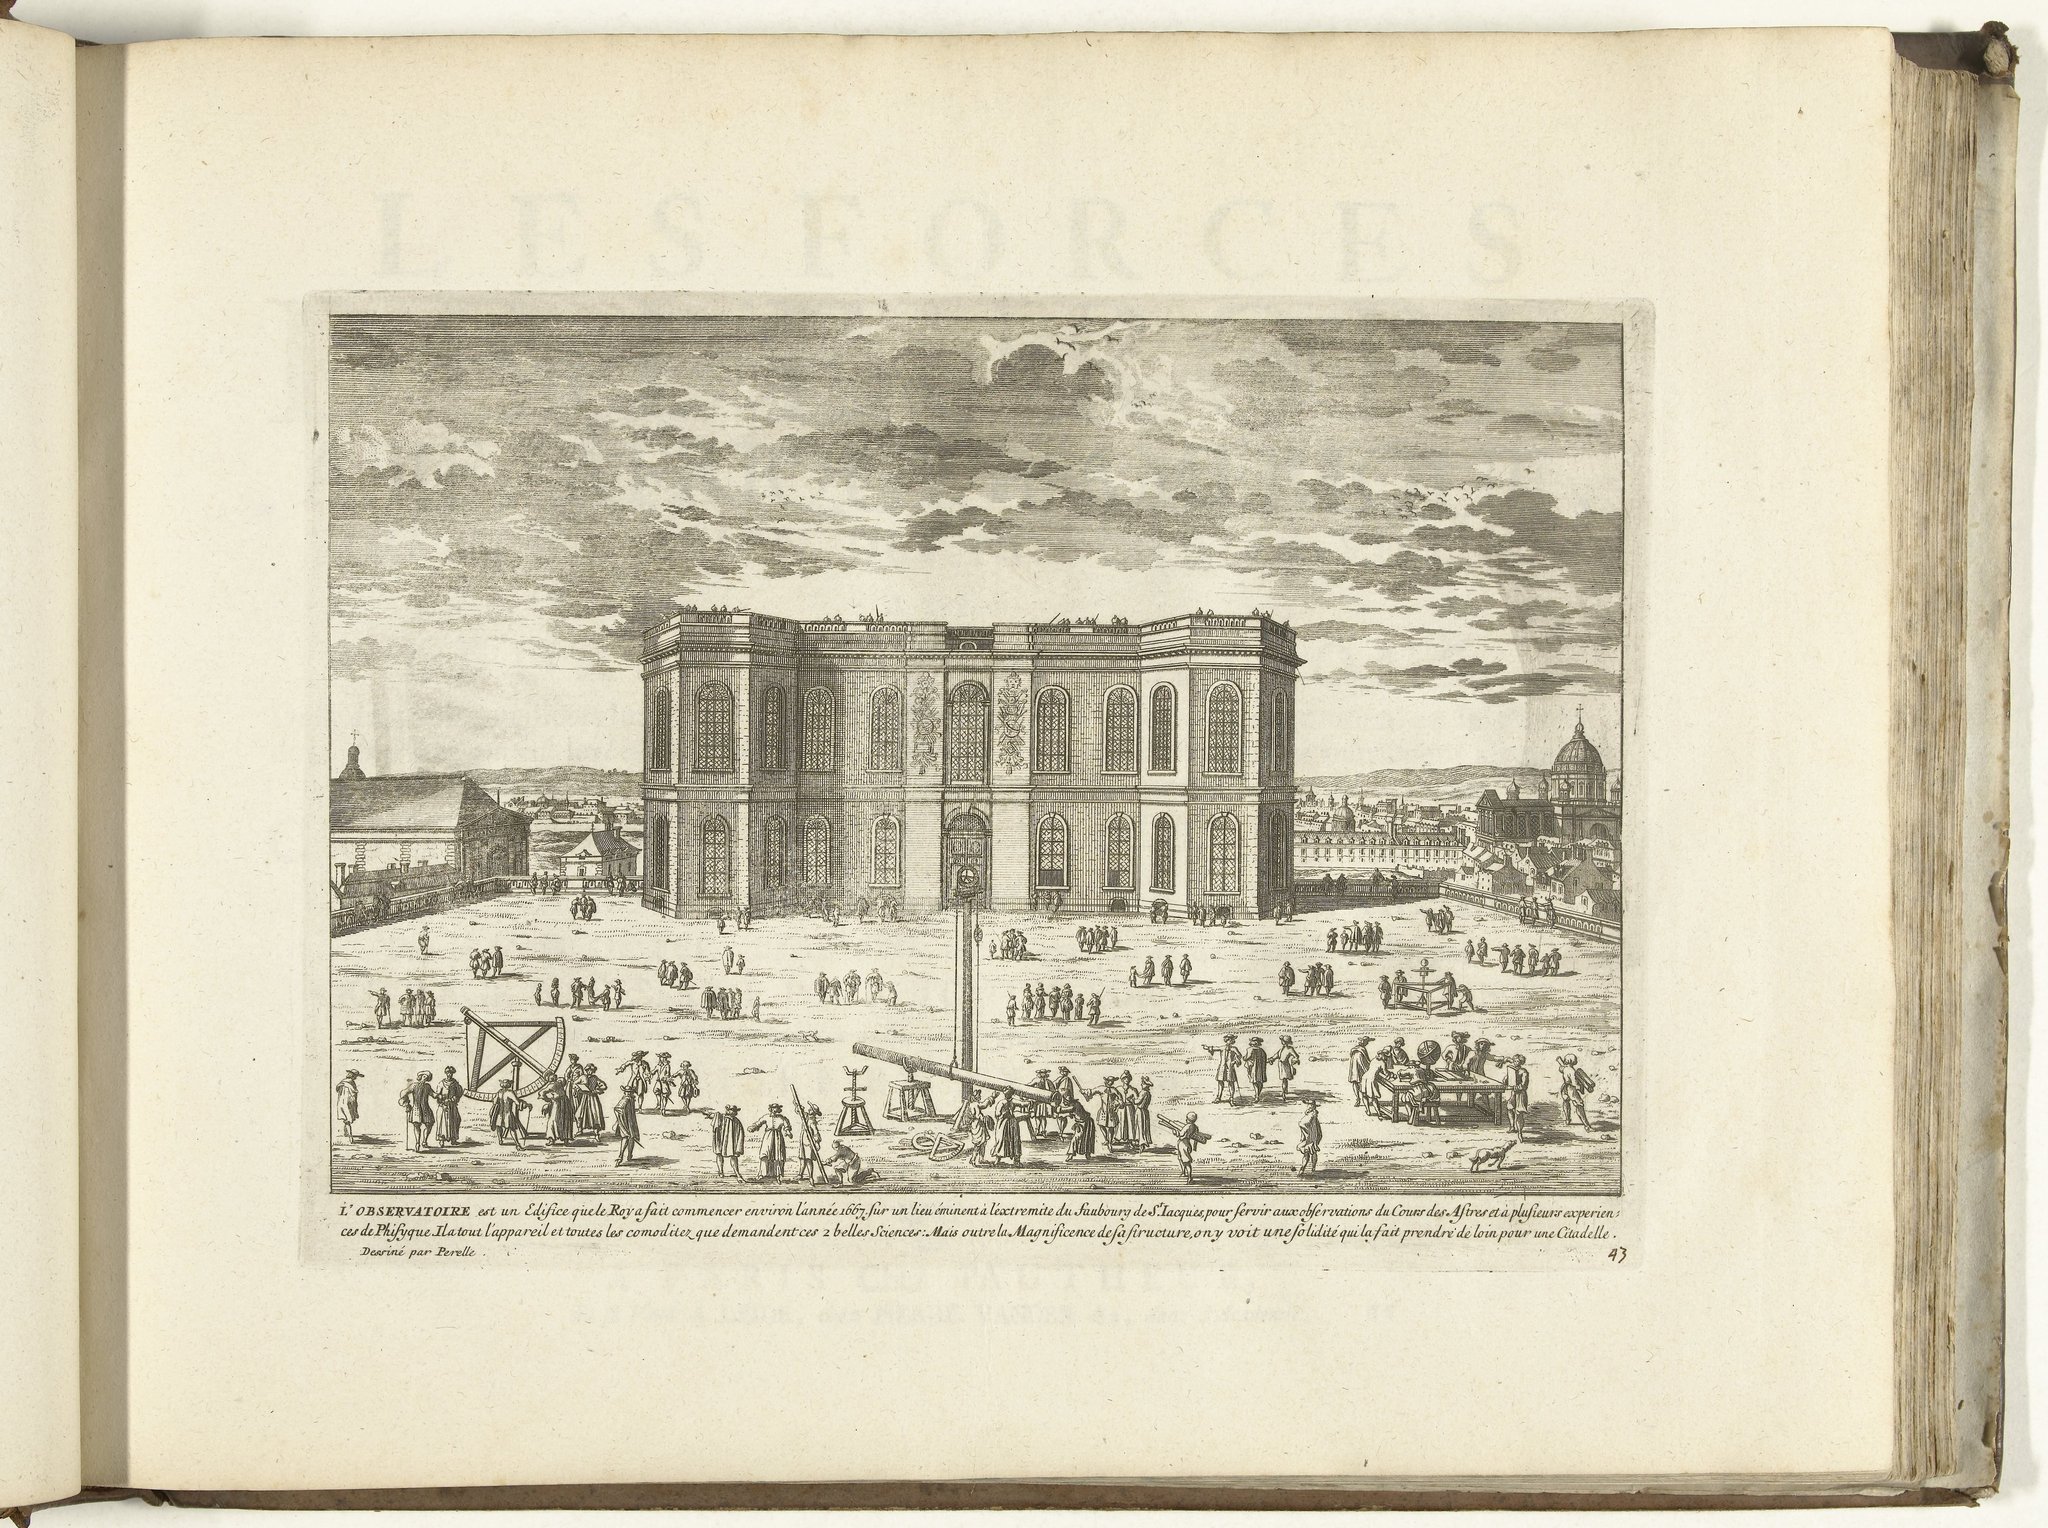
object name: print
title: Gezicht op de Observatoire te Parijs, 1726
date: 1726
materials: paper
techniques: etching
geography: leiden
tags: observatoire de paris, spaanse successieoorlog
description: Gezicht op de Observatoire te Parijs. Op het plein voor het gebouw zijn geleerden bezig met wetenschappelijke experimenten. Plaat nr. 43 in deel II van het prentwerk: Les Forces de l'Europe, Asie, Afrique et Amerique ... Comme aussi les Cartes des Côtes de France et d'Espagne uit 1726, dit eerste deel met 238 met de hand genummerde platen van vermaarde sterke steden en vestingen in het kader van de Spaanse Successieoorlog 1701-1713. Voor het merendeel zijn deze platen gekopieerd naar de anonieme Franse platen van vermaarde sterke steden en vestingen: in Les forces de l'Europe en in: Le theatre de la guerre, dans les Pays-Bas, beide oorspronkelijk uitgegeven door Nicolas de Fer te Parijs (1693-1697) in het kader van de Negenjarige Oorlog. Titel en opschriften in het Frans.